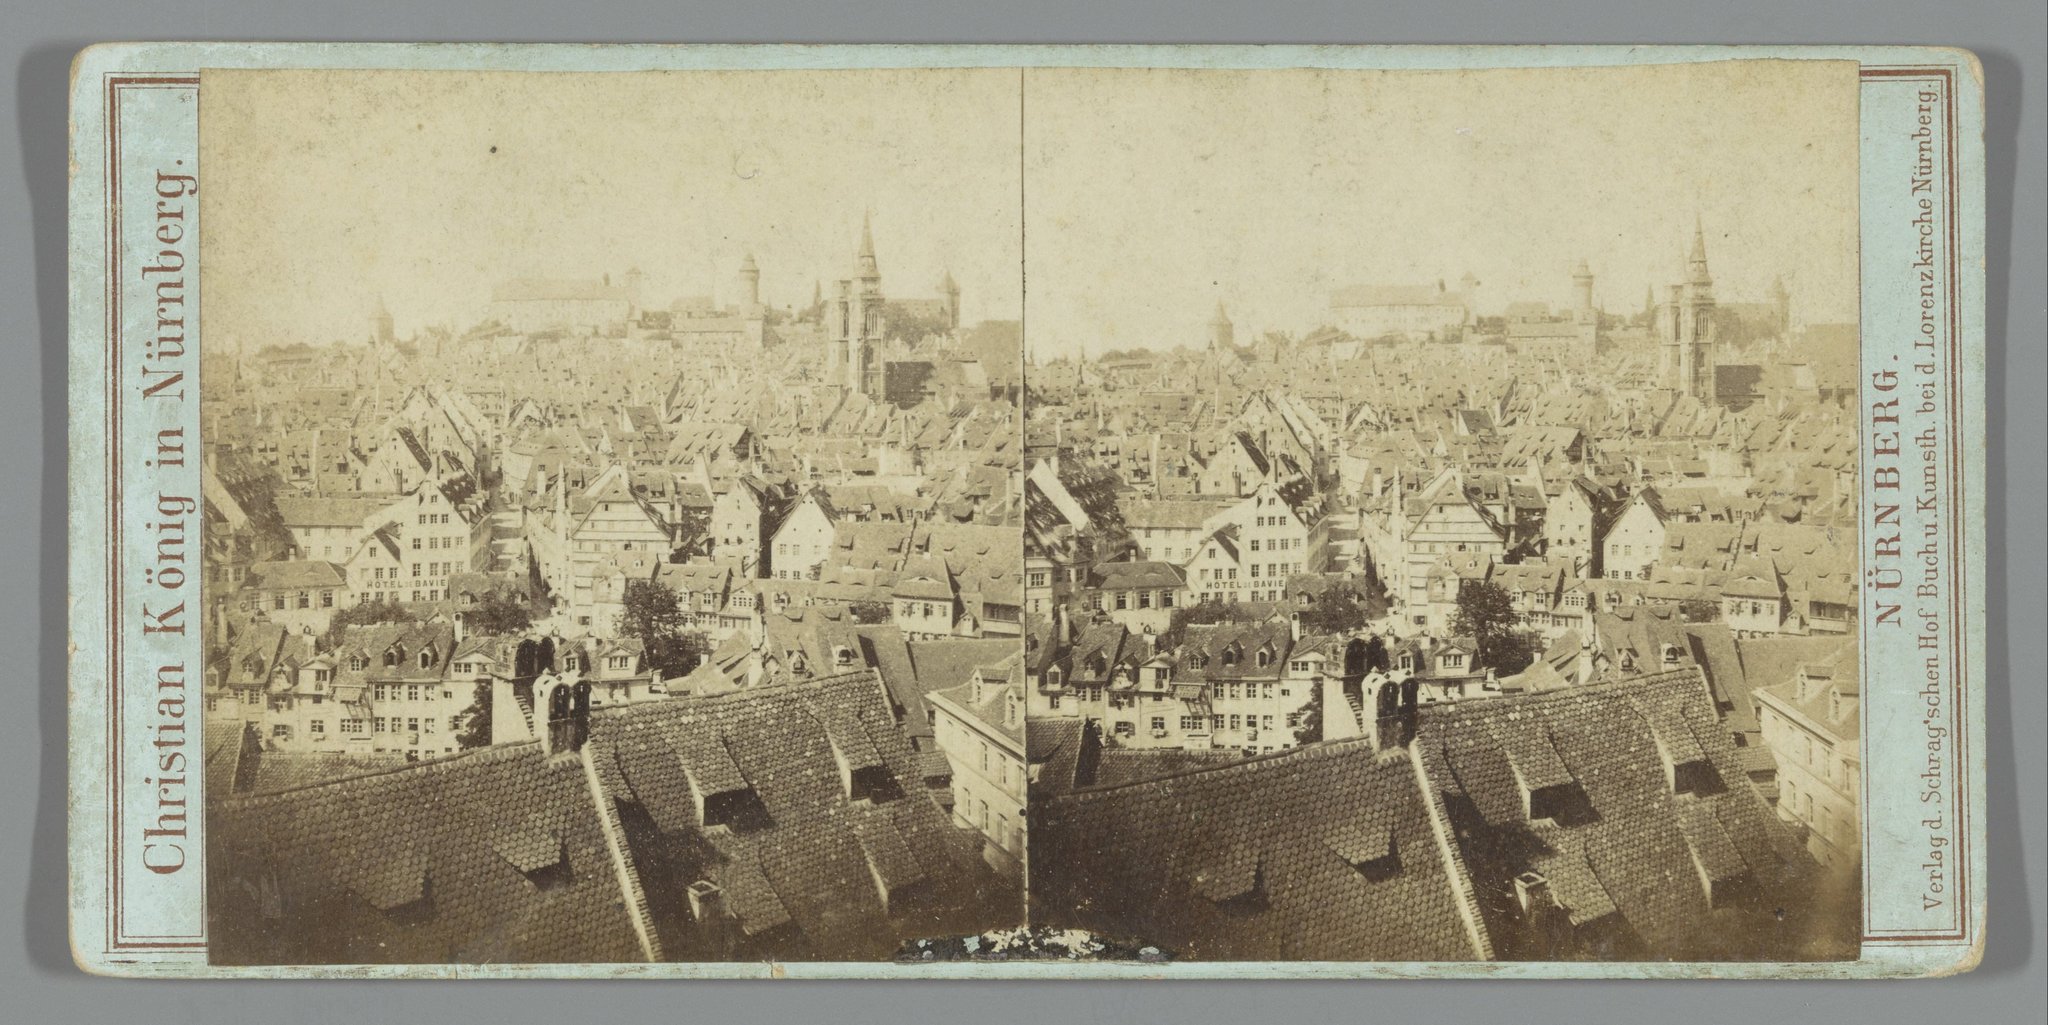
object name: stereograph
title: Gezicht op Neurenberg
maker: c. könig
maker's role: fotograaf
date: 1860-1875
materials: cardboard, photographic support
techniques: albumen print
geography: nuremberg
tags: city-view in general; 'veduta'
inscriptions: inscription: ‘Verlag d. Schrag'schen Hof Buch u. Kunsth. bei d. Lorenzkirche Nürnberg’